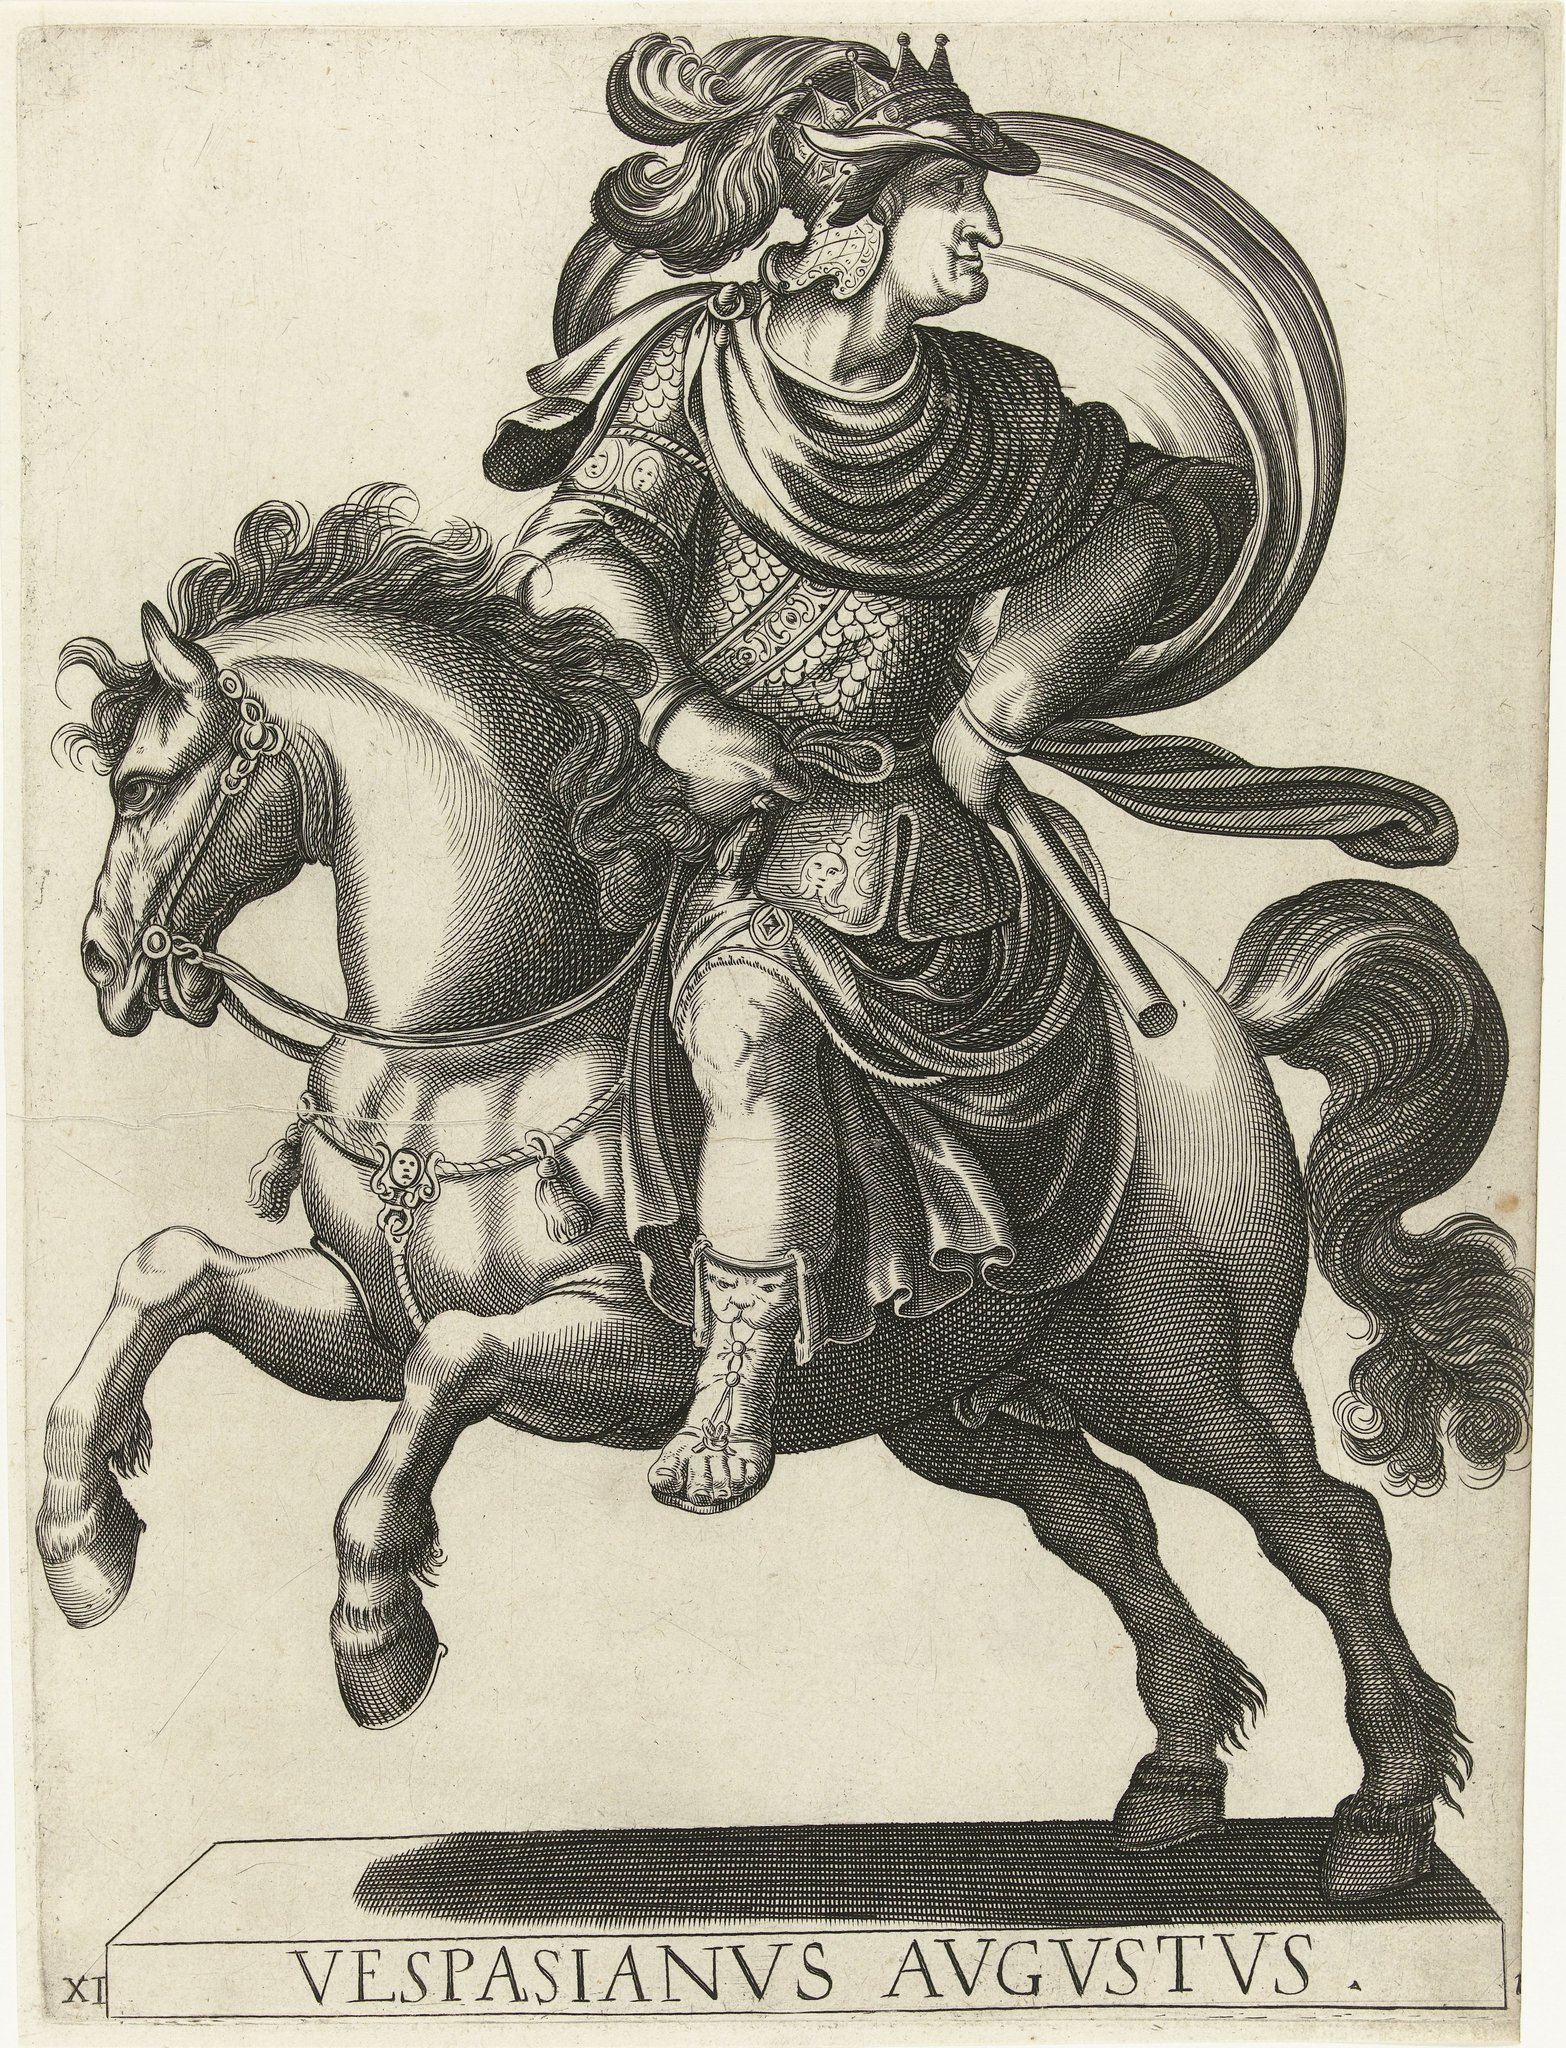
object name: print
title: Ruiterportret van keizer Vespasianus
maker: laurens eillarts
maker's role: print maker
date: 1616-1620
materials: paper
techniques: engraving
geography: italy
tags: aquae cutiliae, keizer, vespasianus (keizer van het romeinse rijk)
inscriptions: collector's mark: Lugt 2228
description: Keizer Vespasianus te paard, en profil afgebeeld terwijl hij naar achter kijkt.